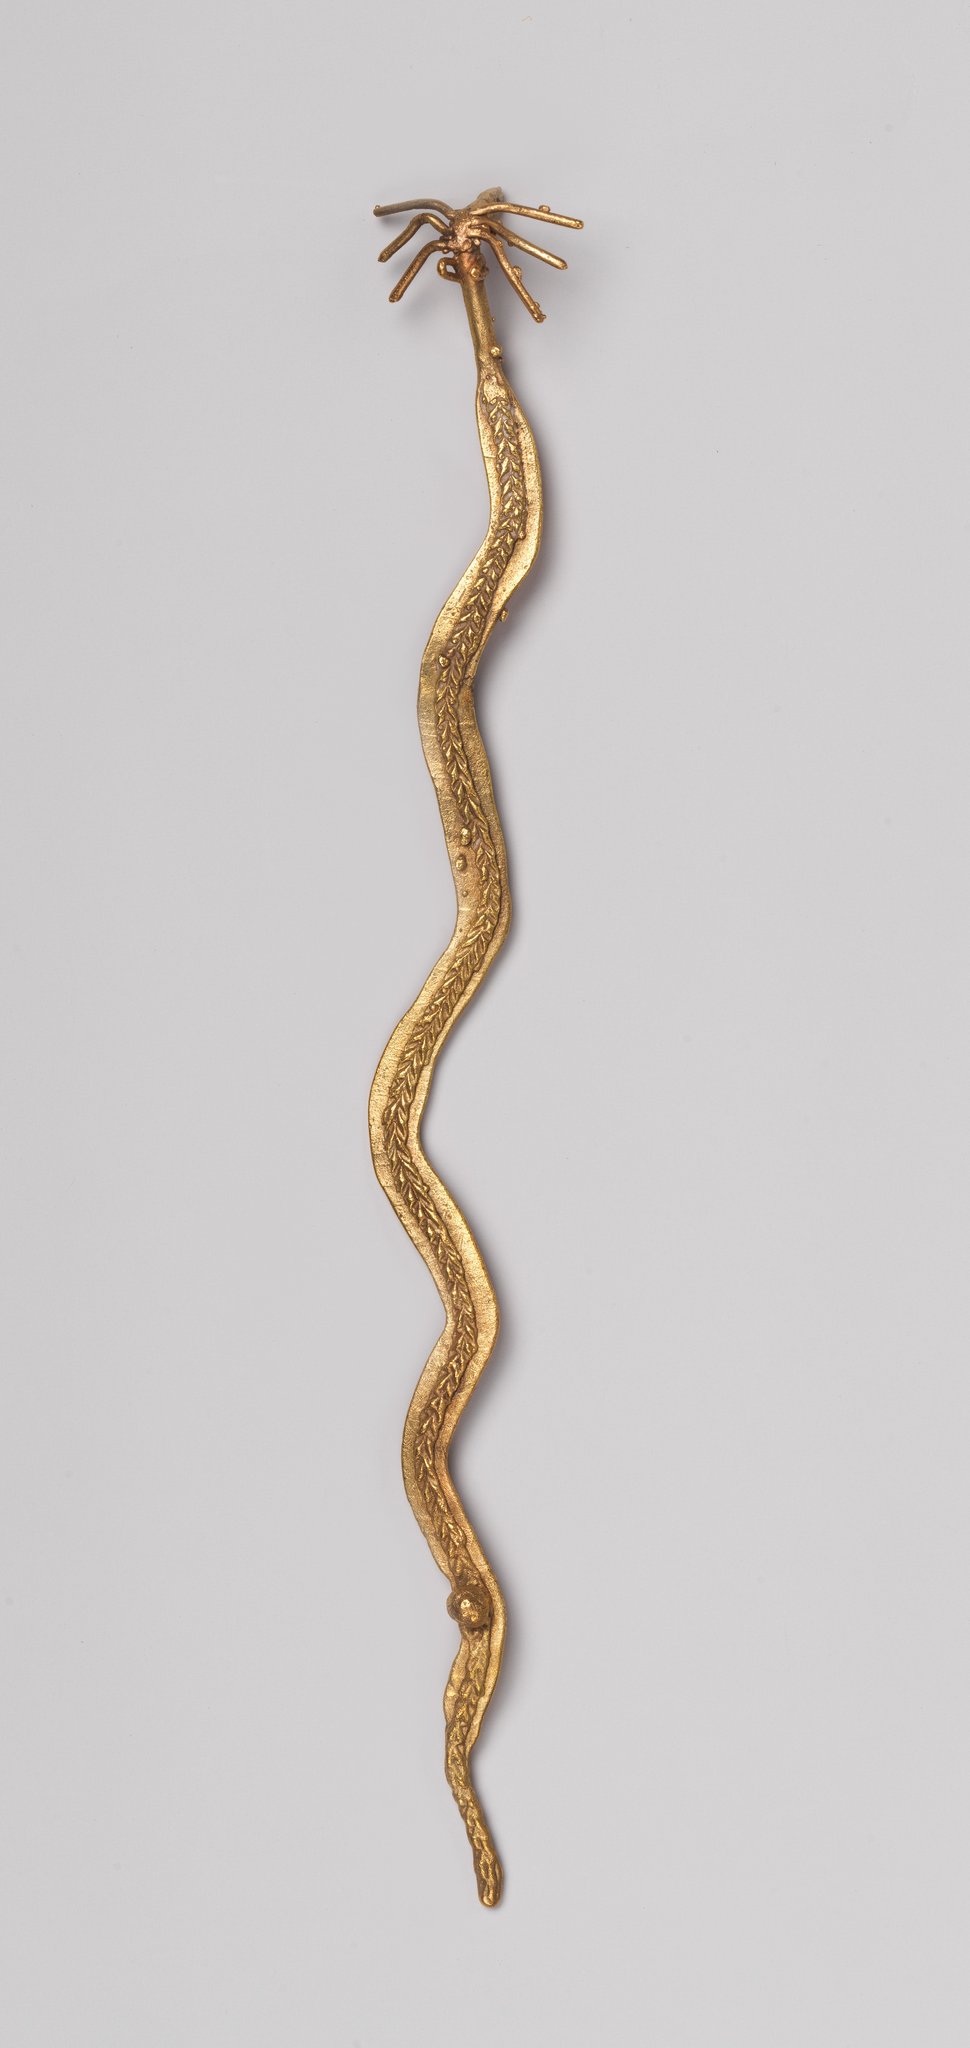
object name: snake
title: Serpent (Tunjo)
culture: muisca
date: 901-1600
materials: gold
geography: colombia